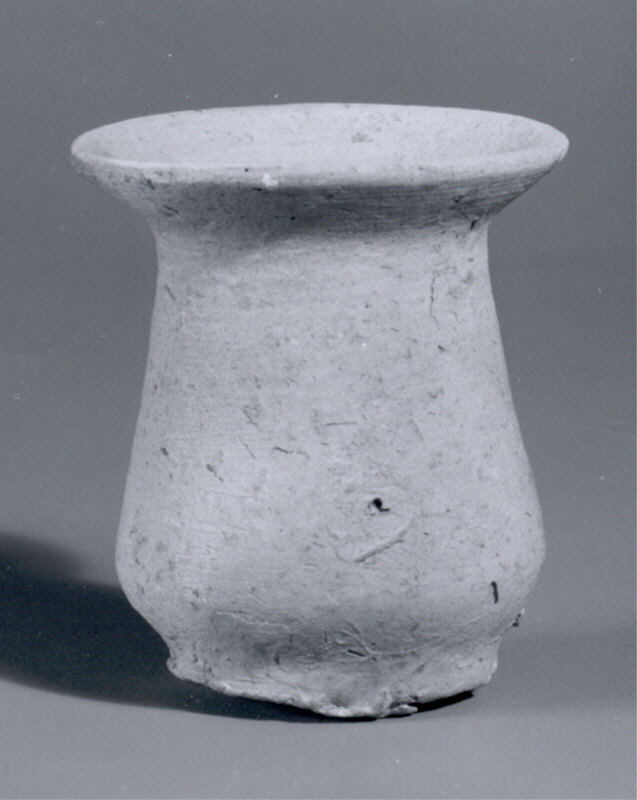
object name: vessel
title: Drinking vessel ("istikan")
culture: assyrian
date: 900-601 BCE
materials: ceramic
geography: mesopotamia